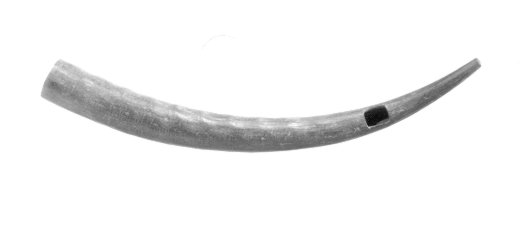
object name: horn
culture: african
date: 1867-1900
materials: horn